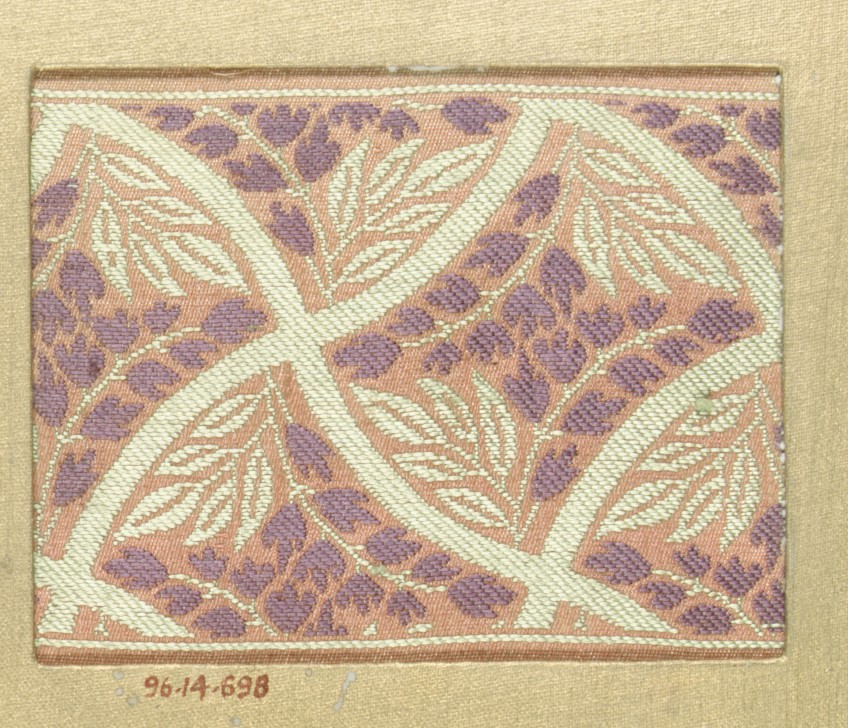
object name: piece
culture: japanese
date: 1701-1900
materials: silk